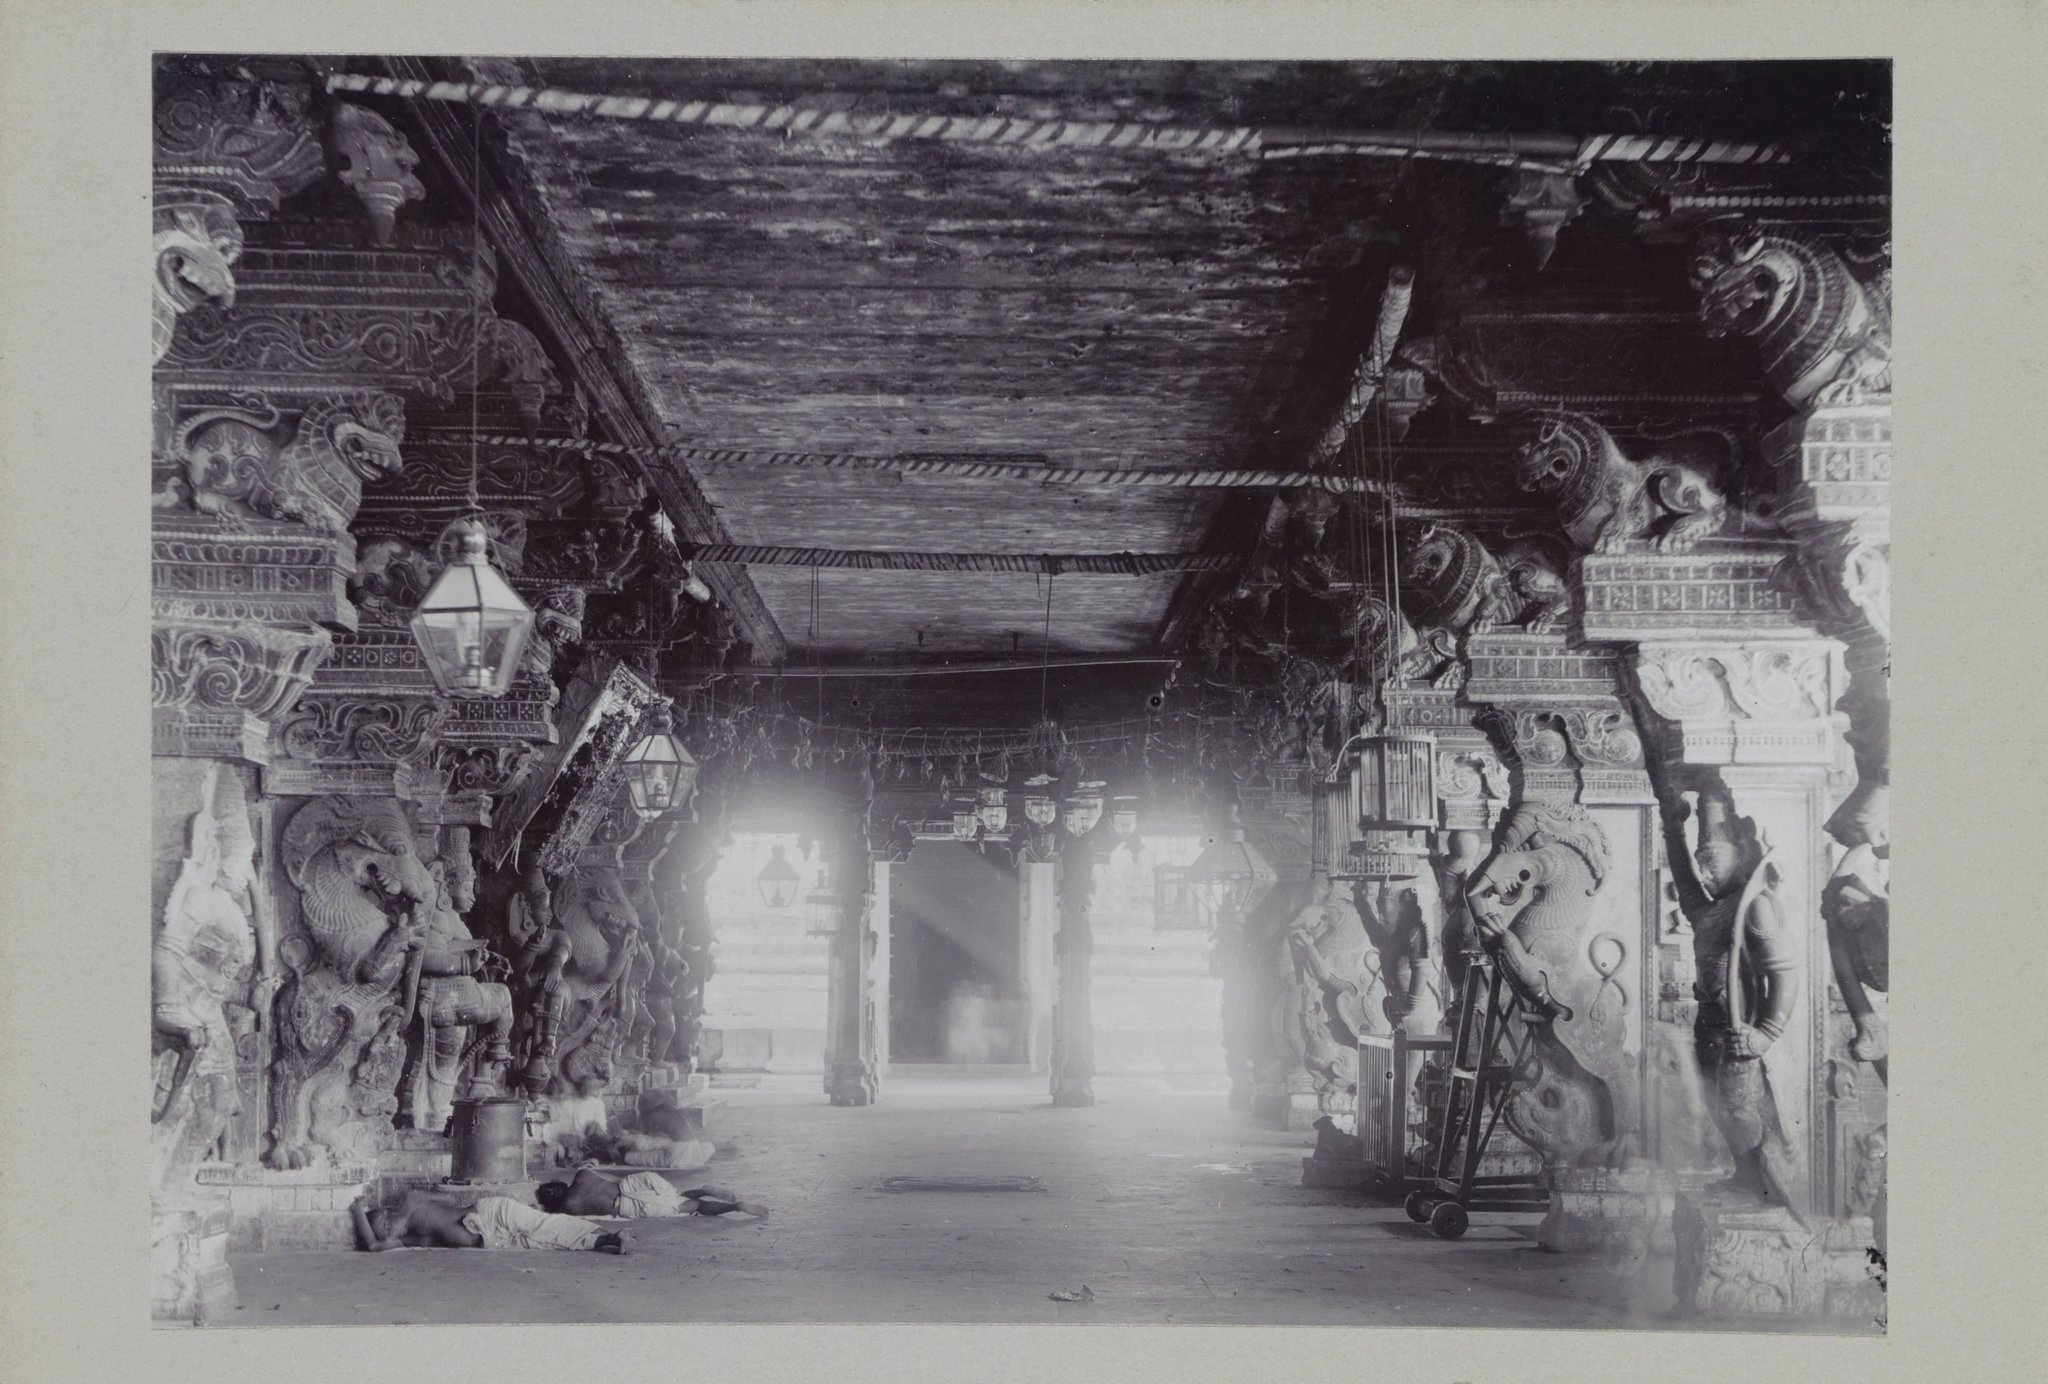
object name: photograph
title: Interior of the Meenakshi temple at Madurai, Tamil Nadu, India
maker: Anonymous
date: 1895-1915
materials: cardboard, paper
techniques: gelatin silver print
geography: madurai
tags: madurai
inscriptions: annotation: ‘77a Tempel te Madura.’